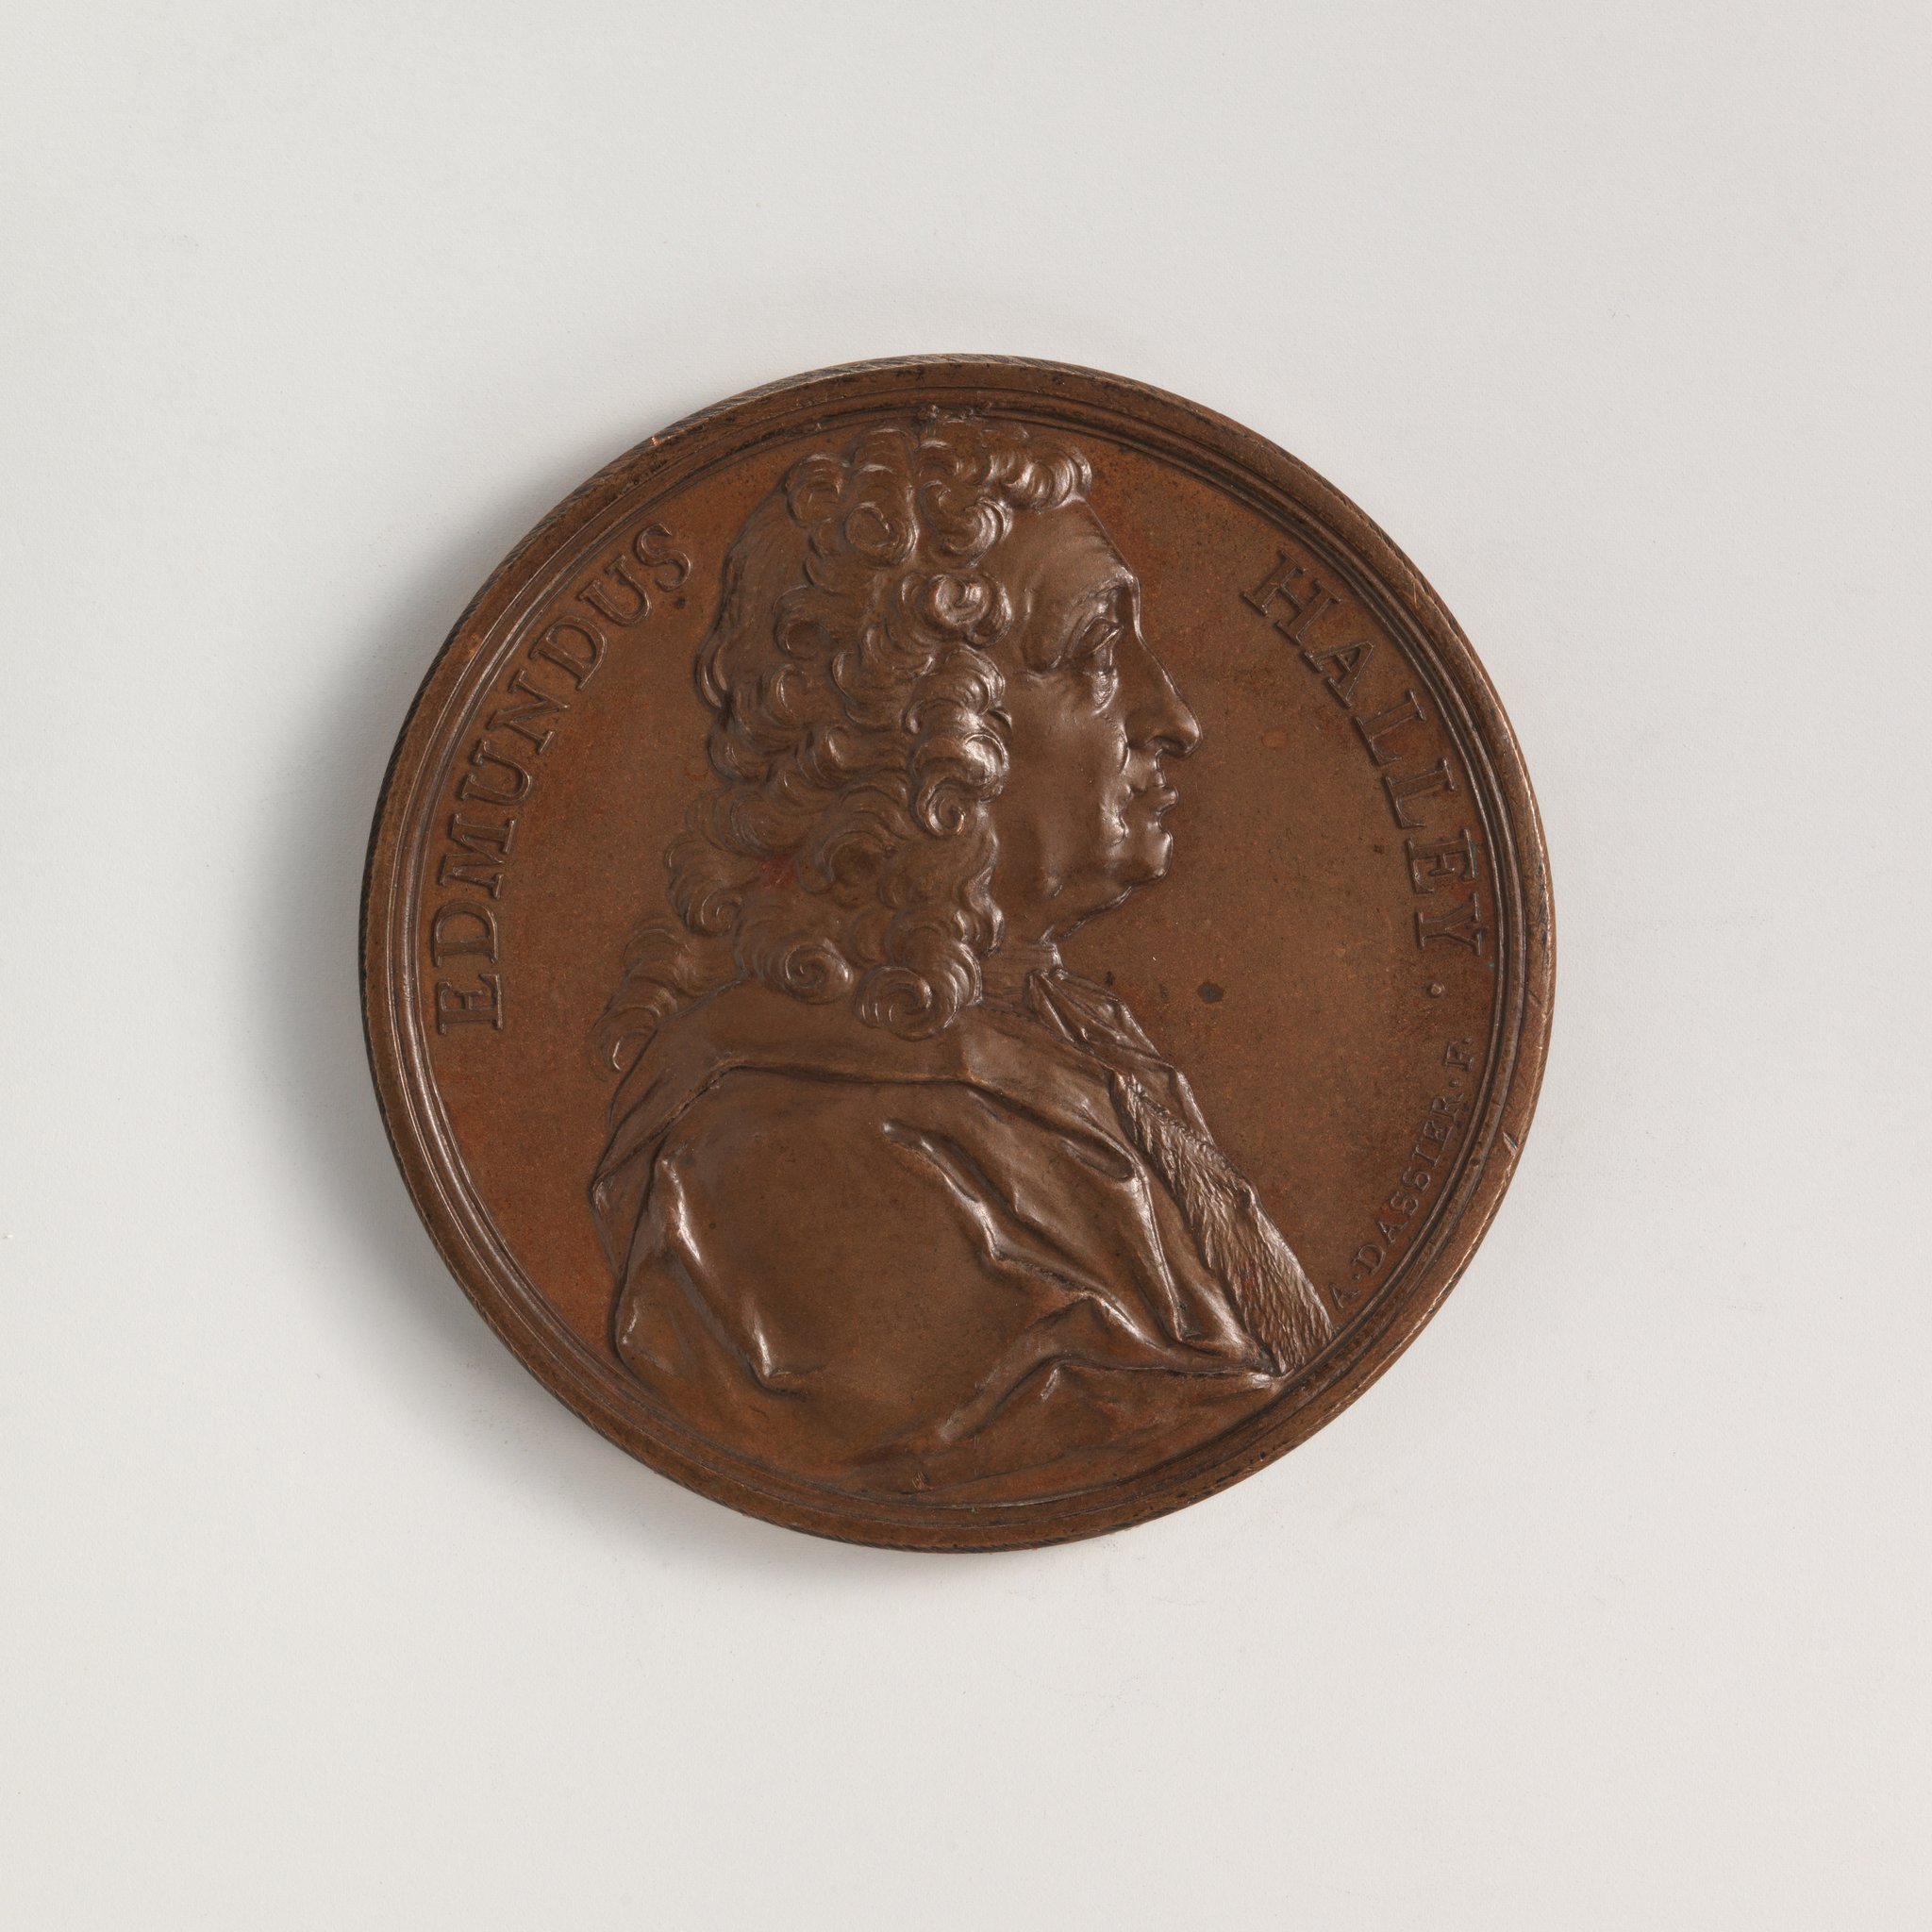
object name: medal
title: Sir Edmund Halley (1656–1742)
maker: jacques-antoine dassier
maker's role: artist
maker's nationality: swiss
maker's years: 1715-1759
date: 1744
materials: bronze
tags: men,profiles